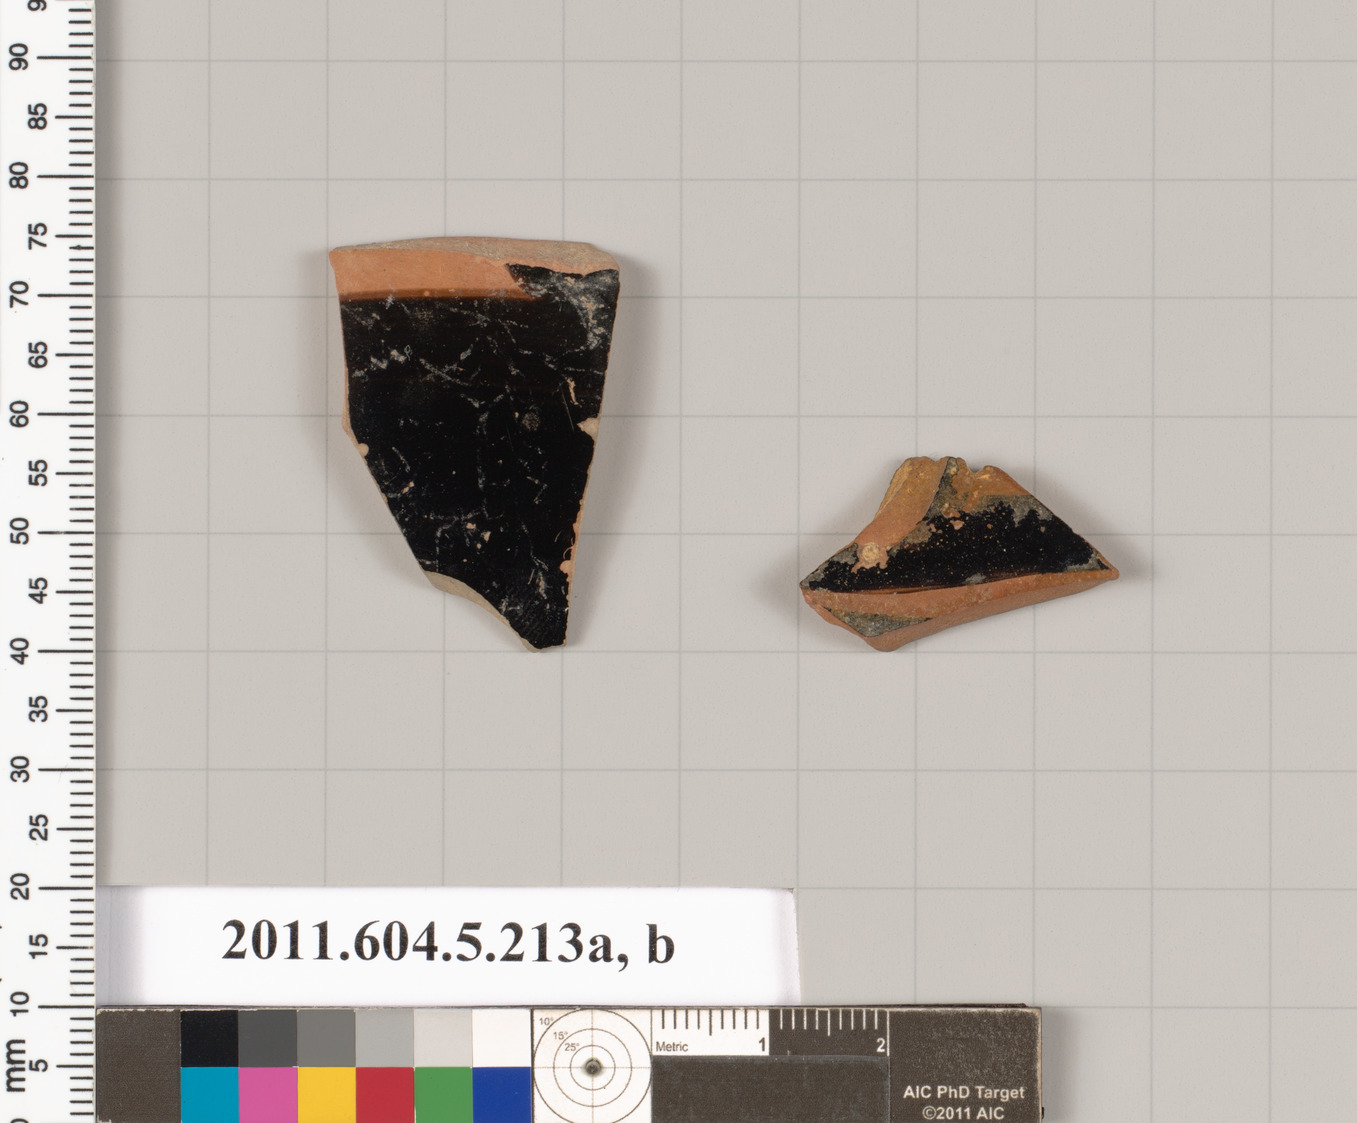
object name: kylix fragment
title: Terracotta fragment of kylikes (drinking cups)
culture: greek, attic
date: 600-401 BCE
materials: terracotta